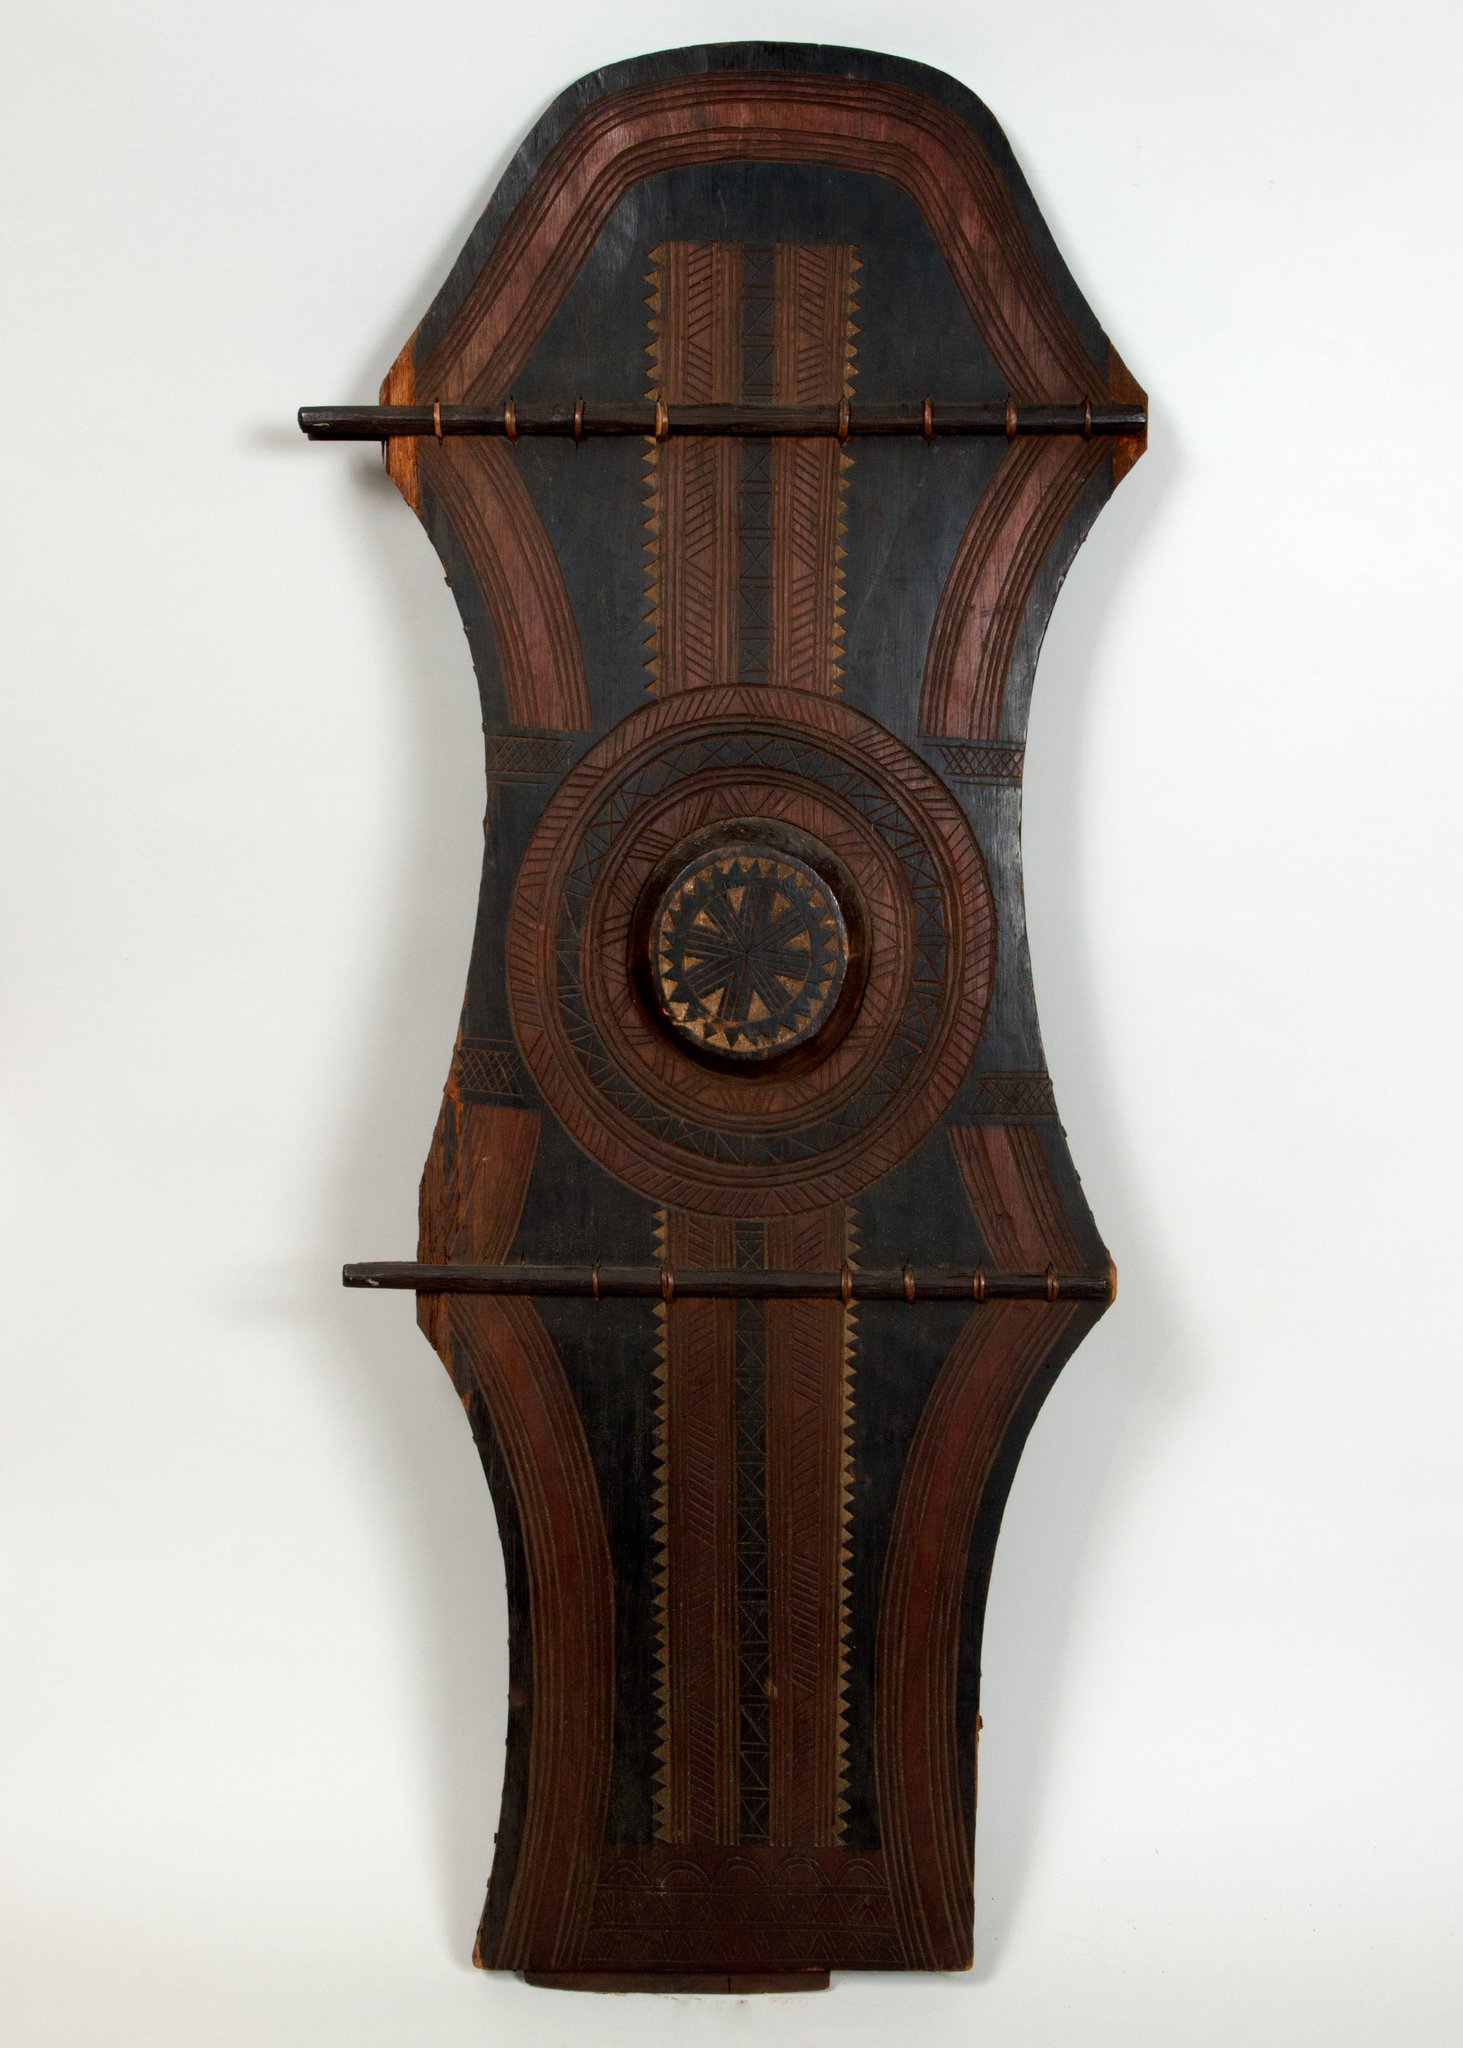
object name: shield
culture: philippine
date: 1701-1900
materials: wood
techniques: polychromy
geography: philippines